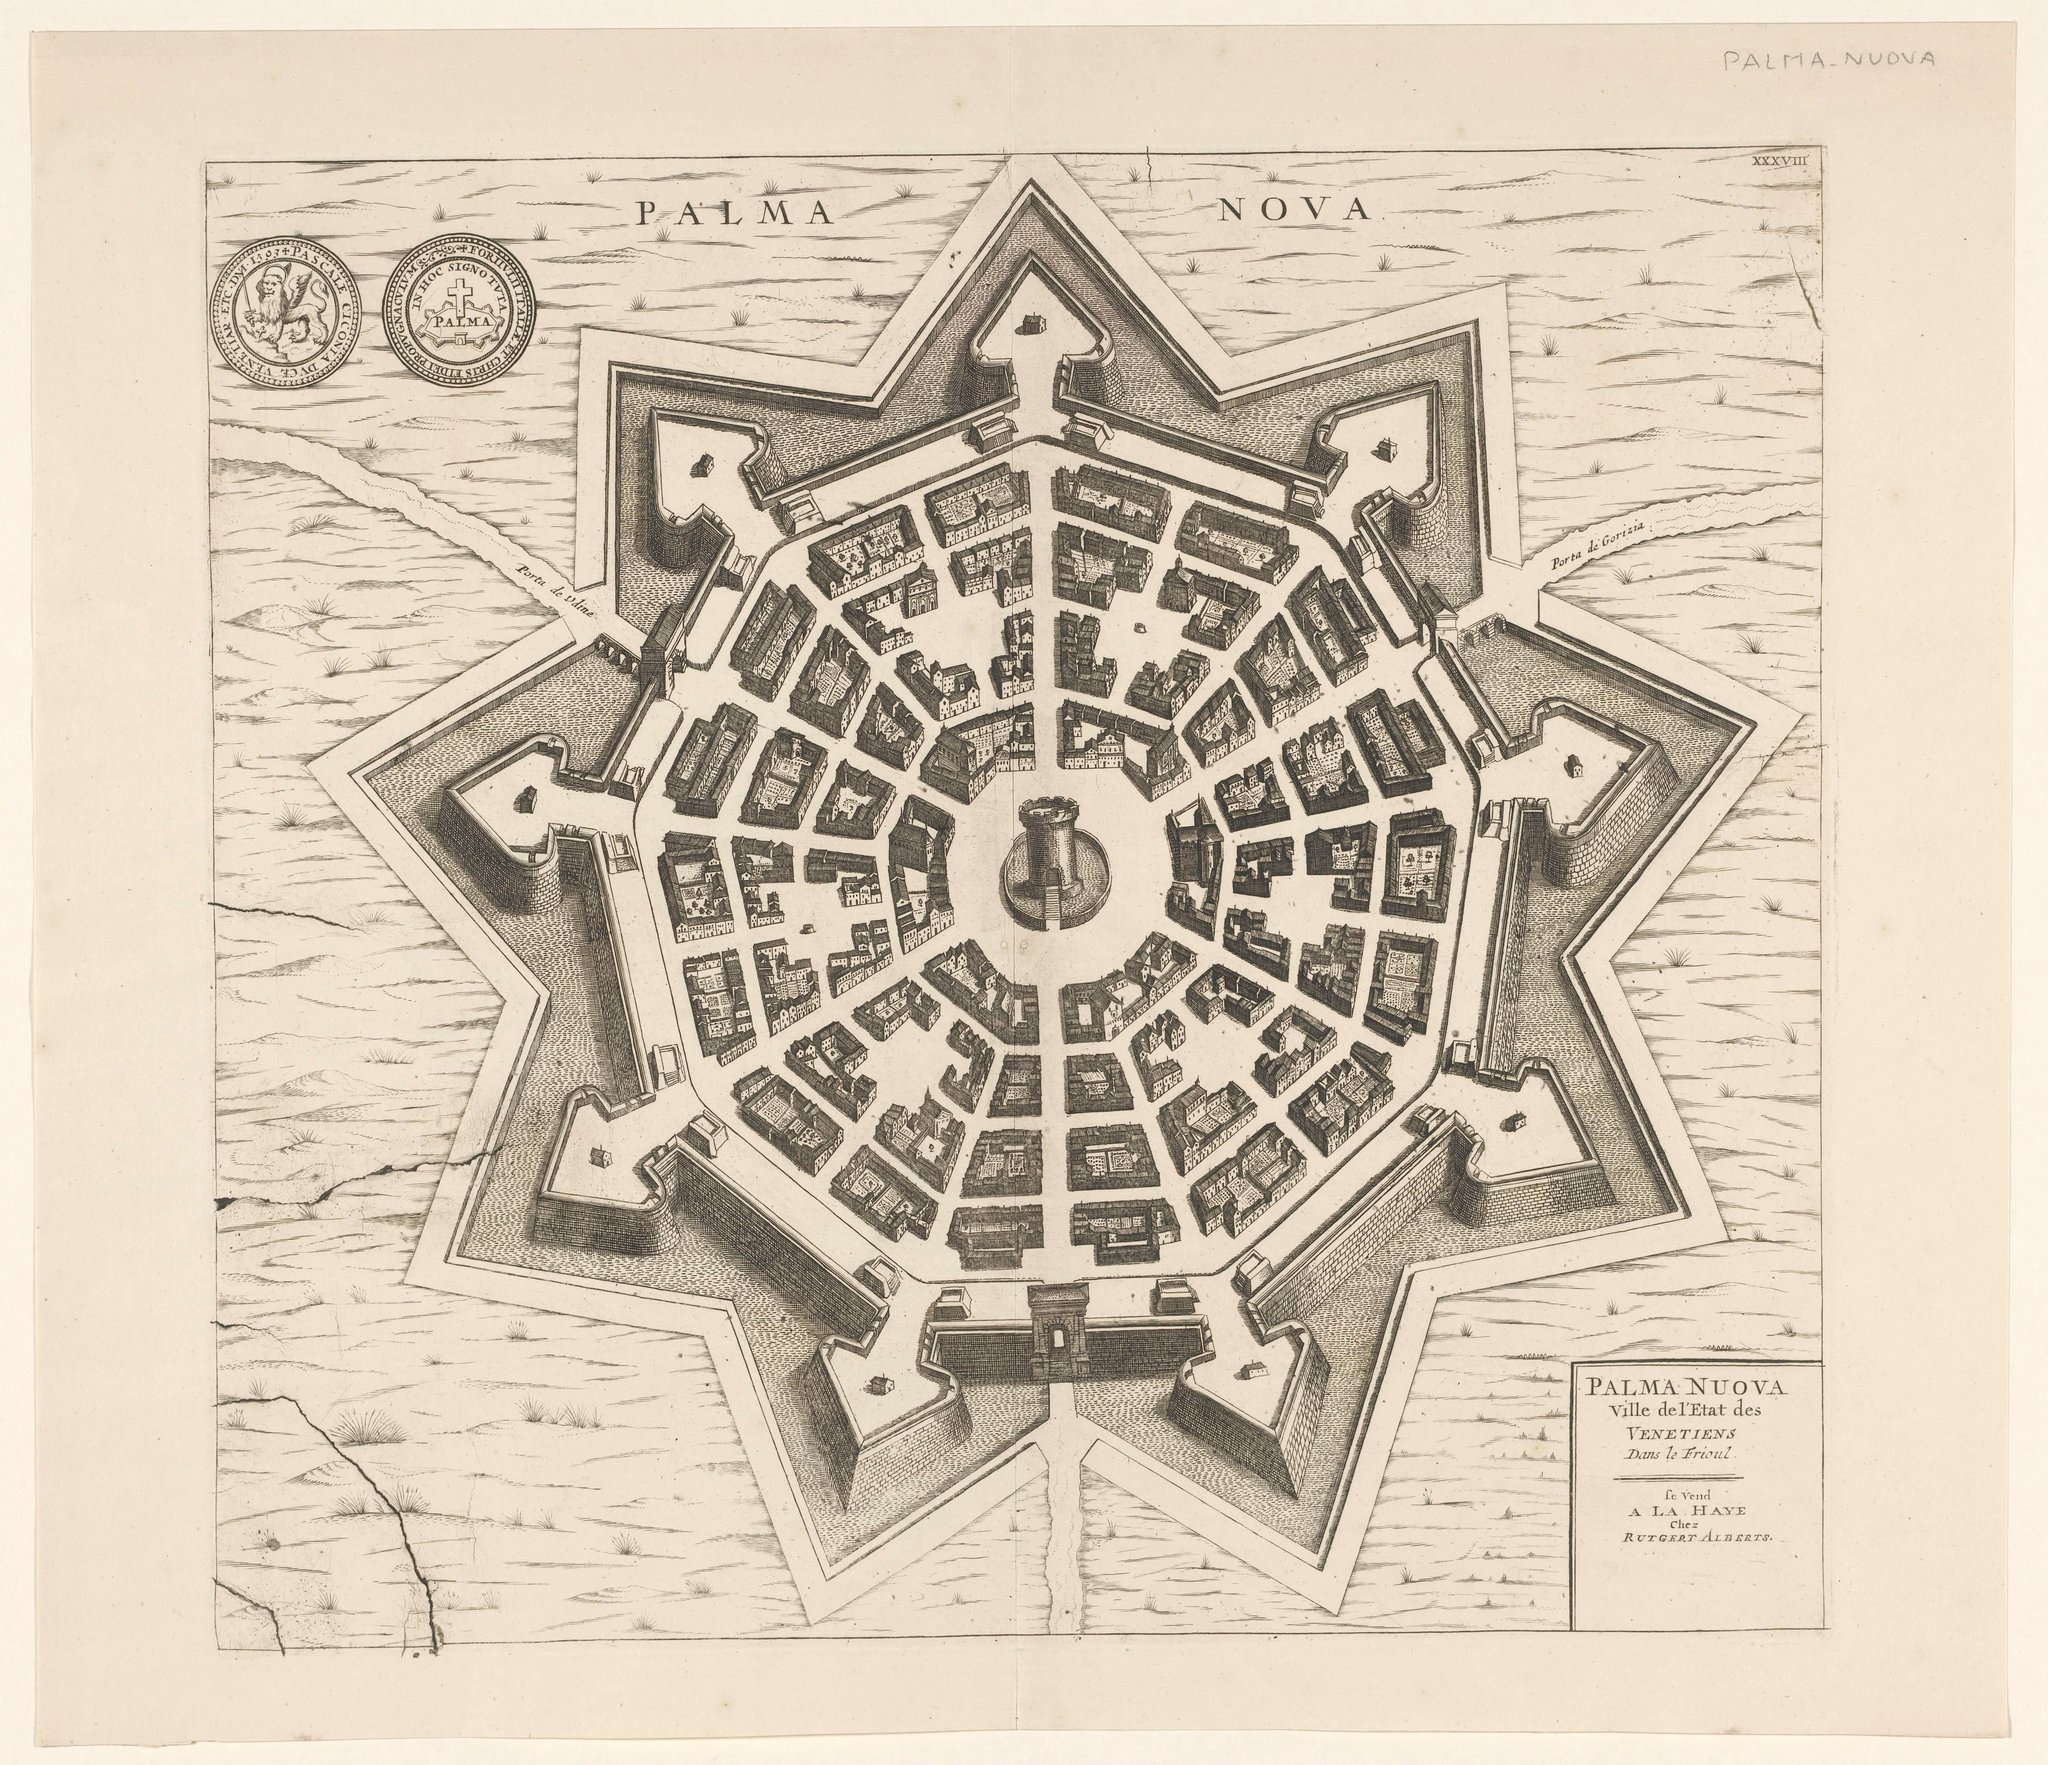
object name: area plan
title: Palma Nova / Palma Nuova ville de l'etat des Venetiens dans le Frioul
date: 1704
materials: paper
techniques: engraving, etching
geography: the hague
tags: fortified city, maps of cities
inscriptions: collector's mark: Lugt 2228